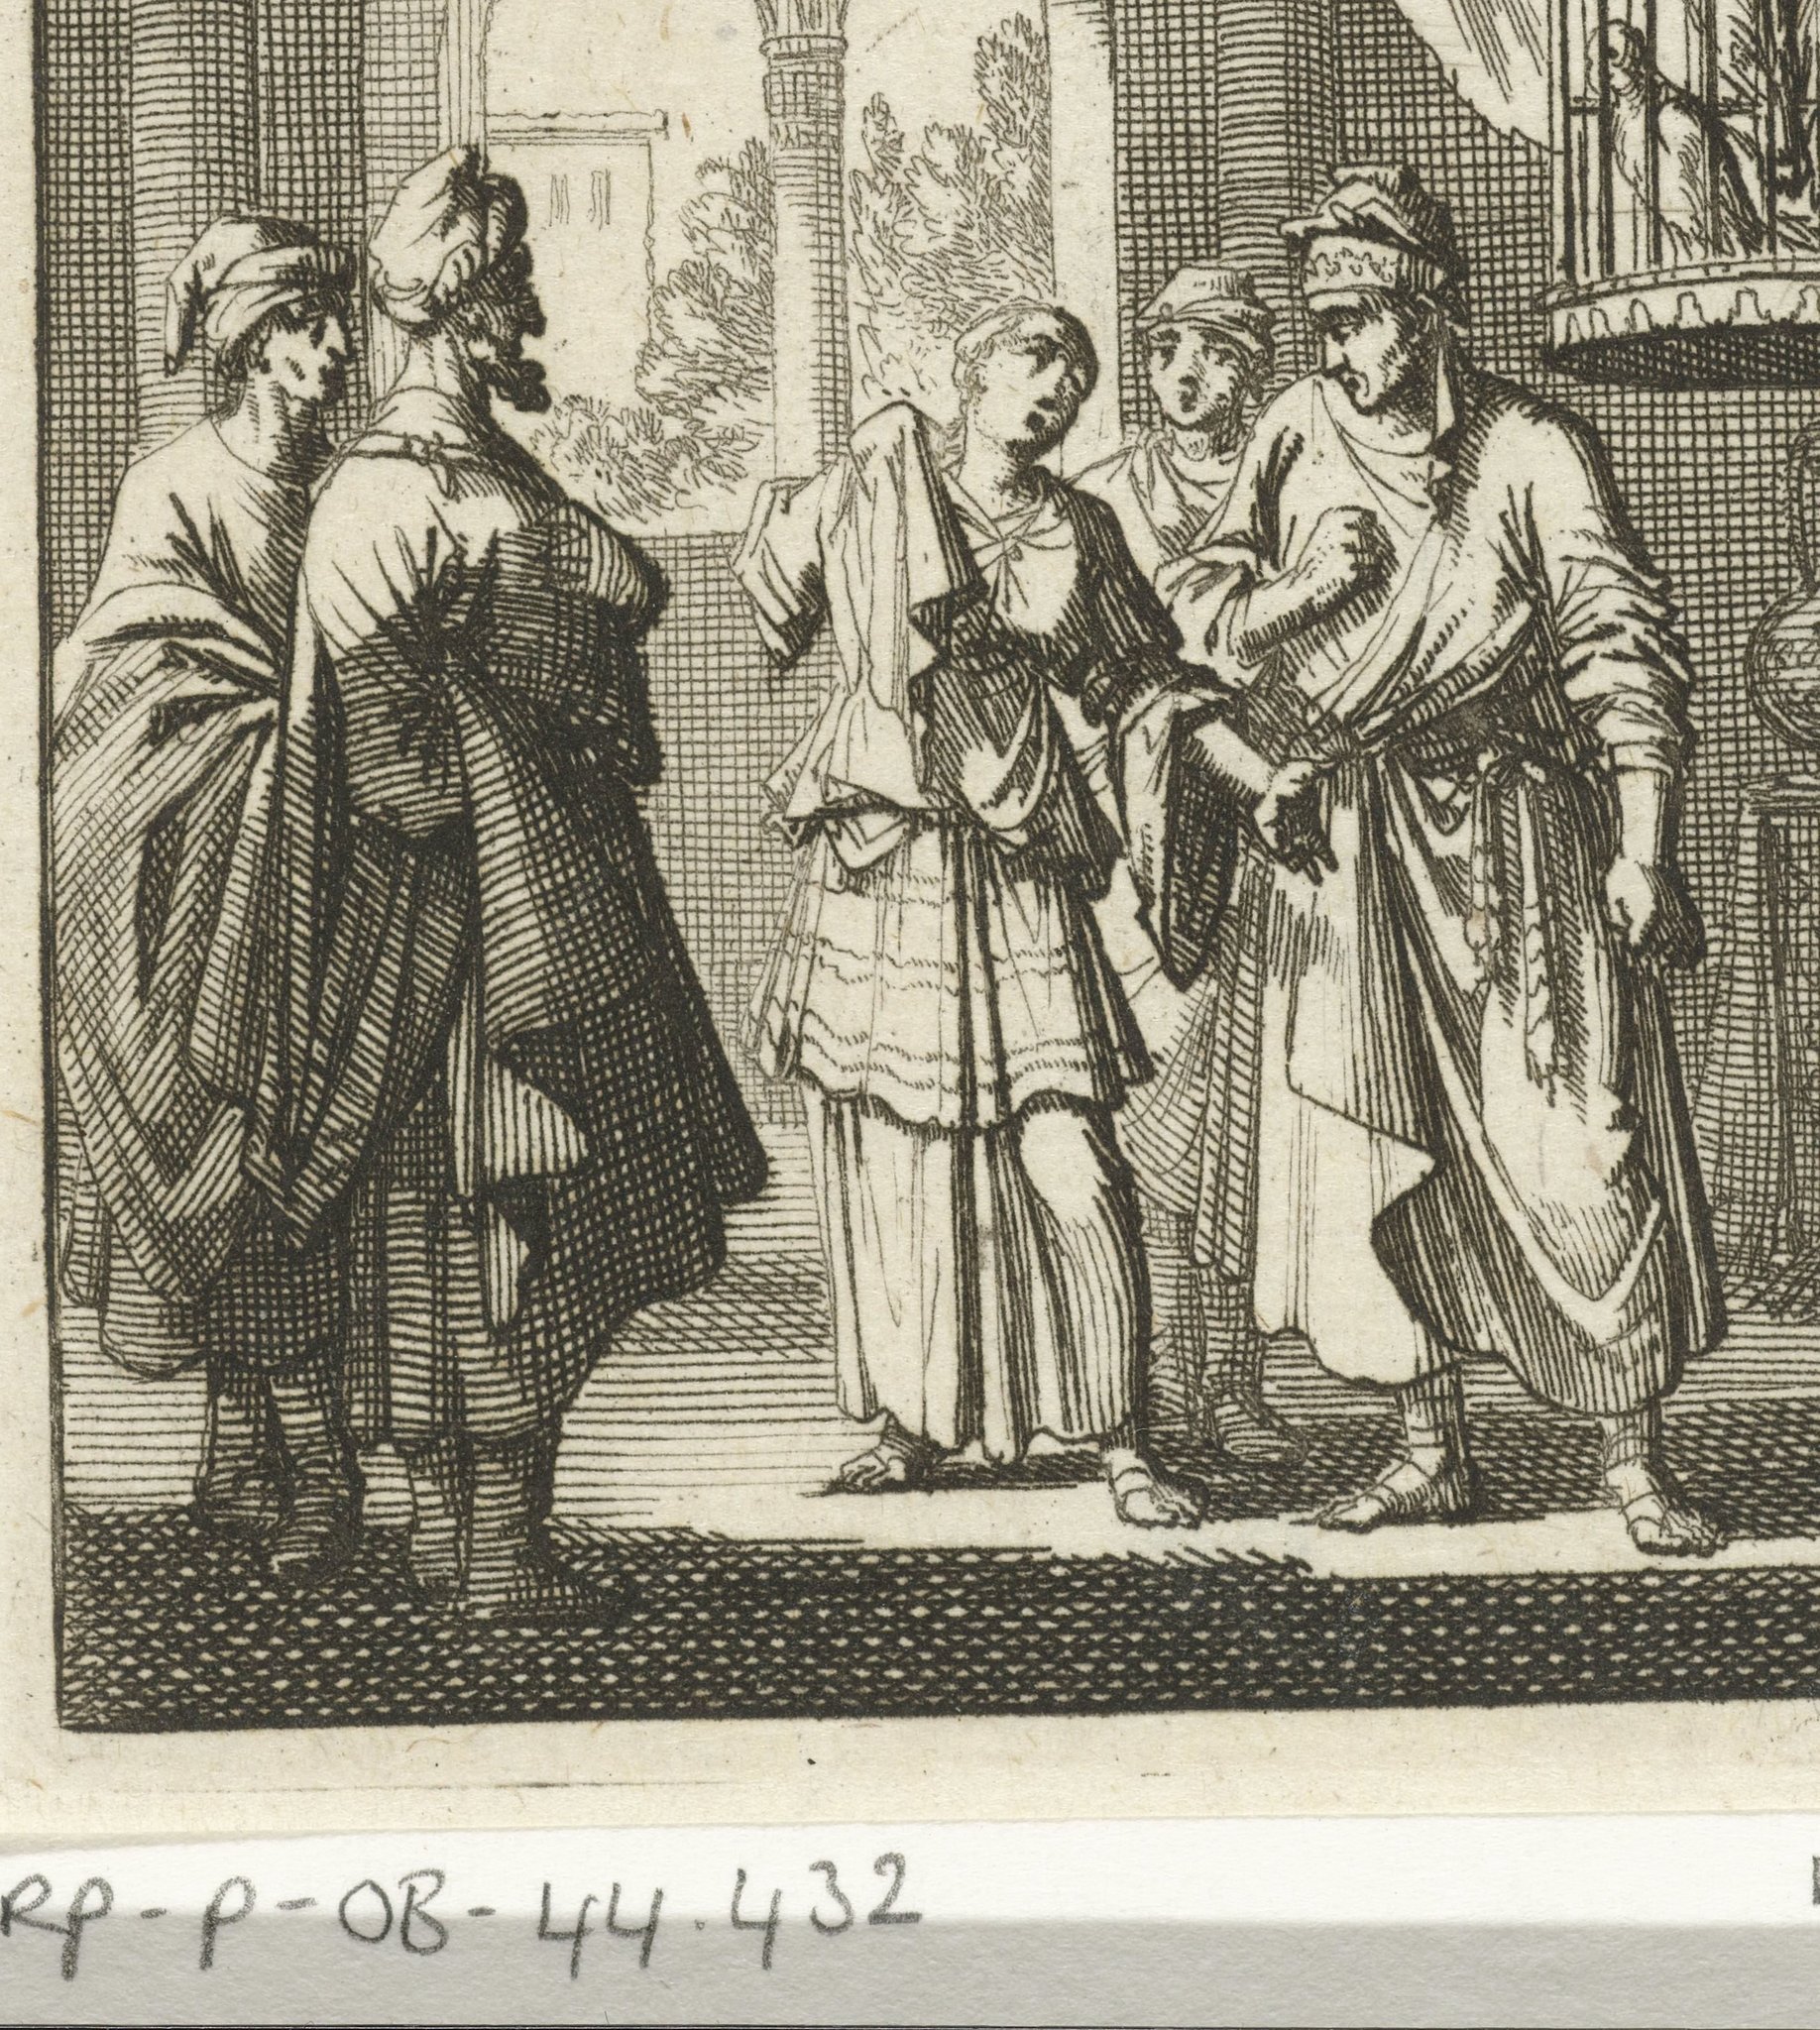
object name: book illustration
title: Man spreekt zijn wenende huisvrouw toe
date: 1693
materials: paper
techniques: etching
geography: amsterdam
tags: marriage, married couple, 'matrimonium', crying, shouting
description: Illustratie uit: Duĳkerius, Johannes. Voorbeeldzels der oude wyzen. Waar in (...) de menschelijke hartstogten (...) behandeld worden. Amsterdam: Aart Wolsgrein, 1693, p. 207.